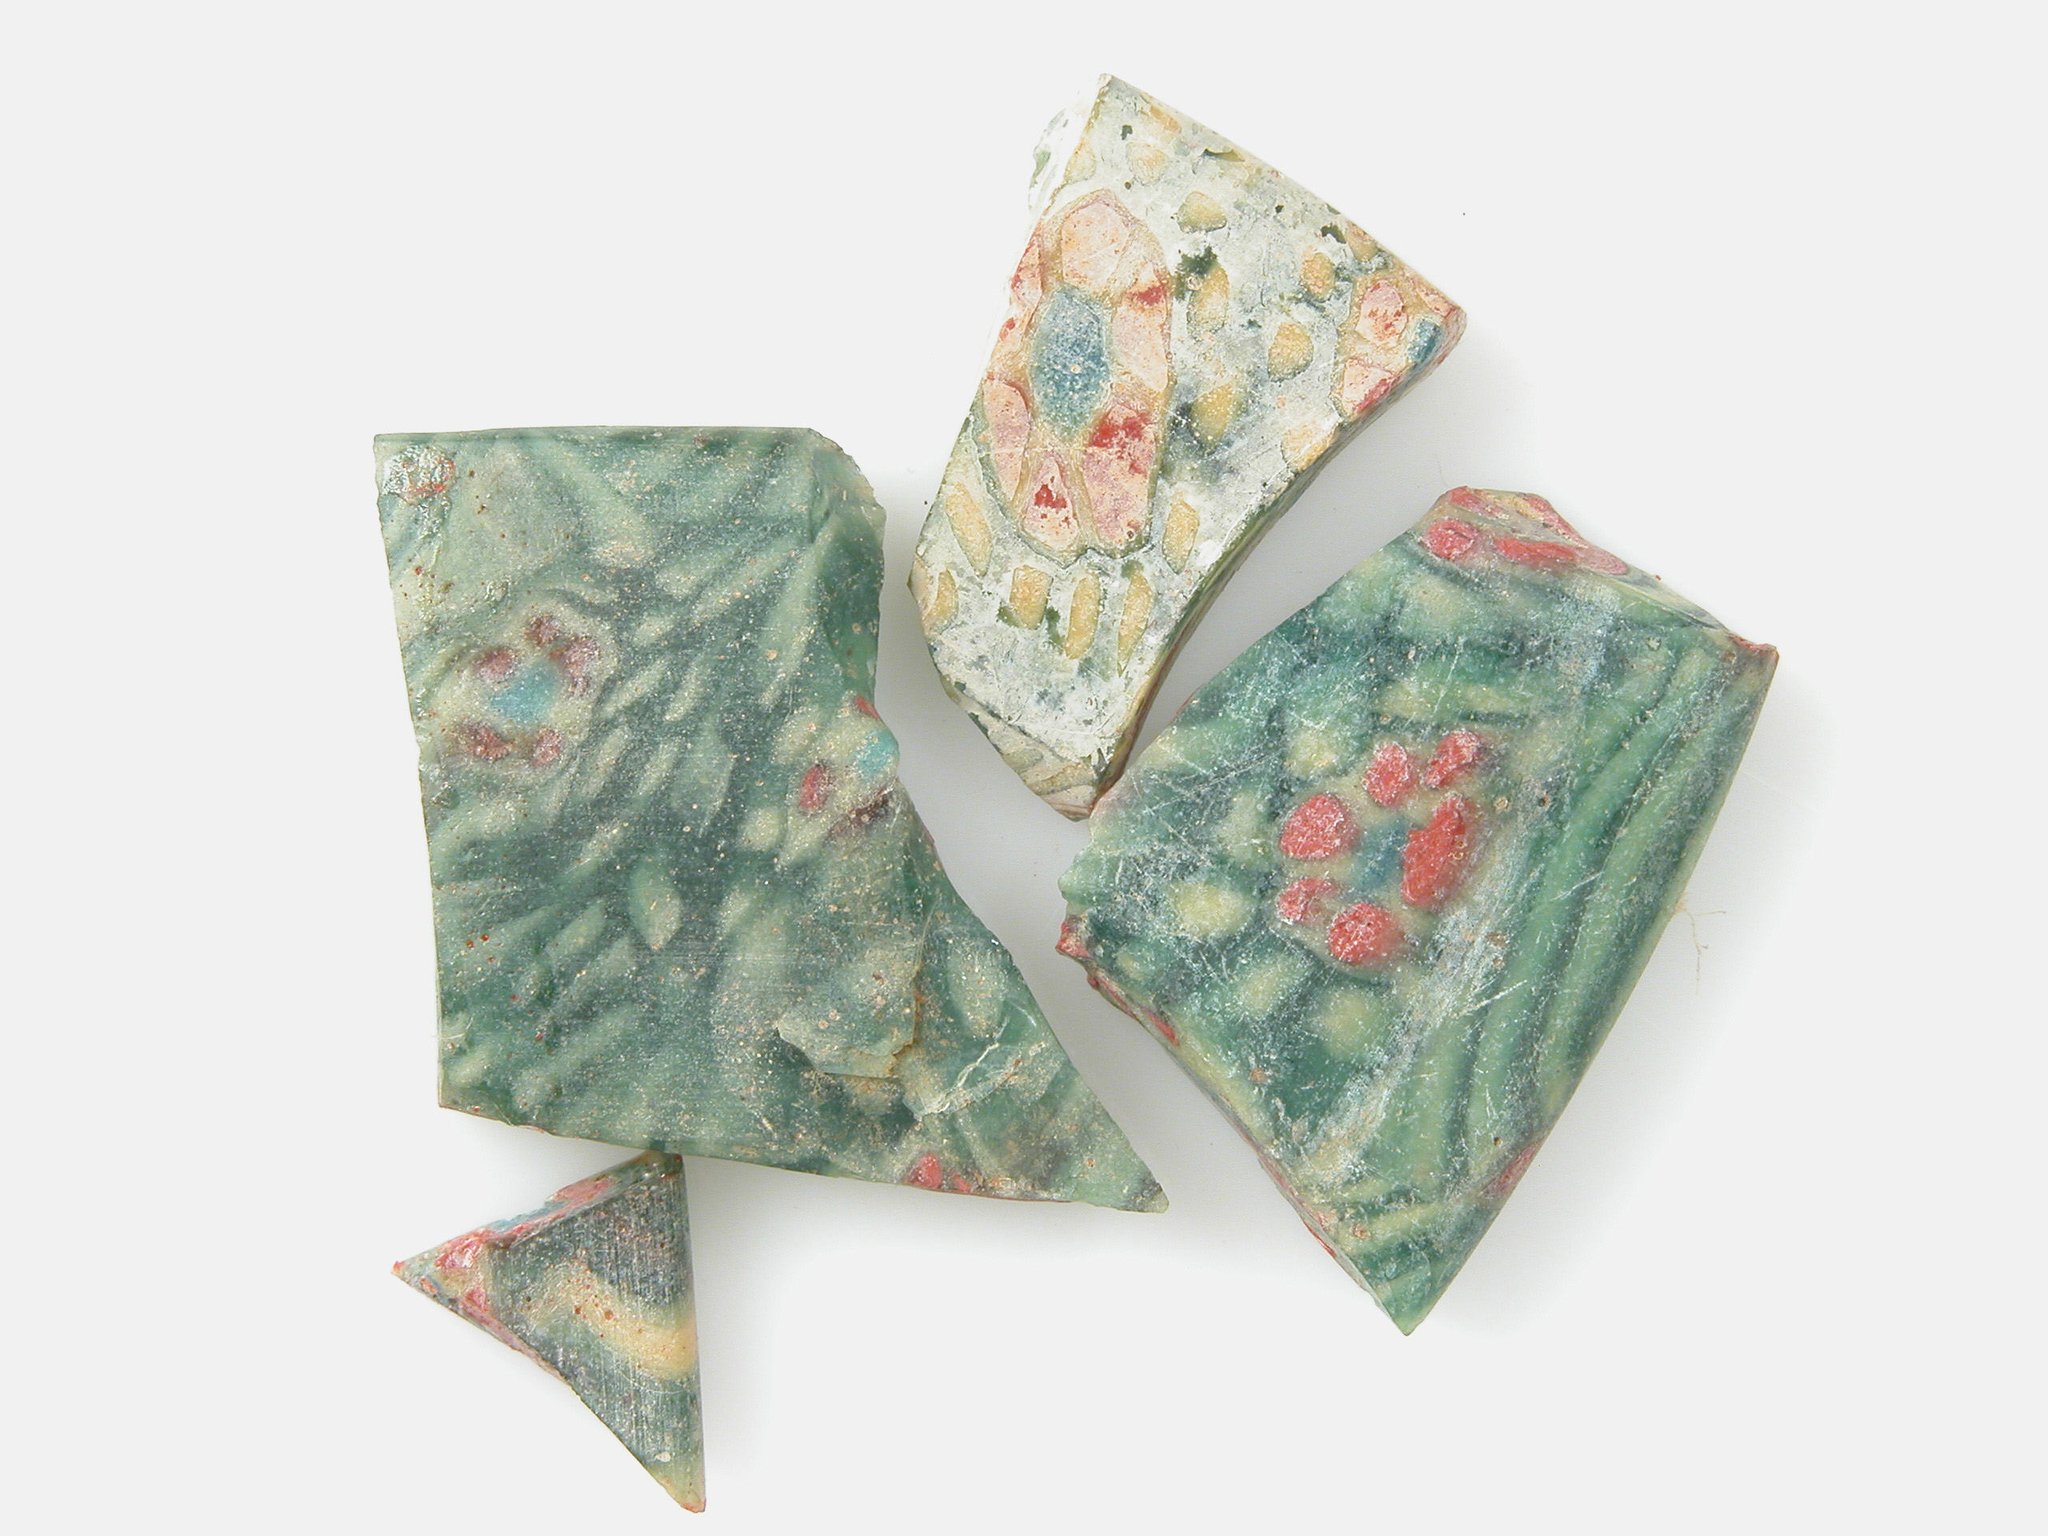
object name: fragment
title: Glass Fragments from a Vessel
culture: coptic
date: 301-433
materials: glass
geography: egypt